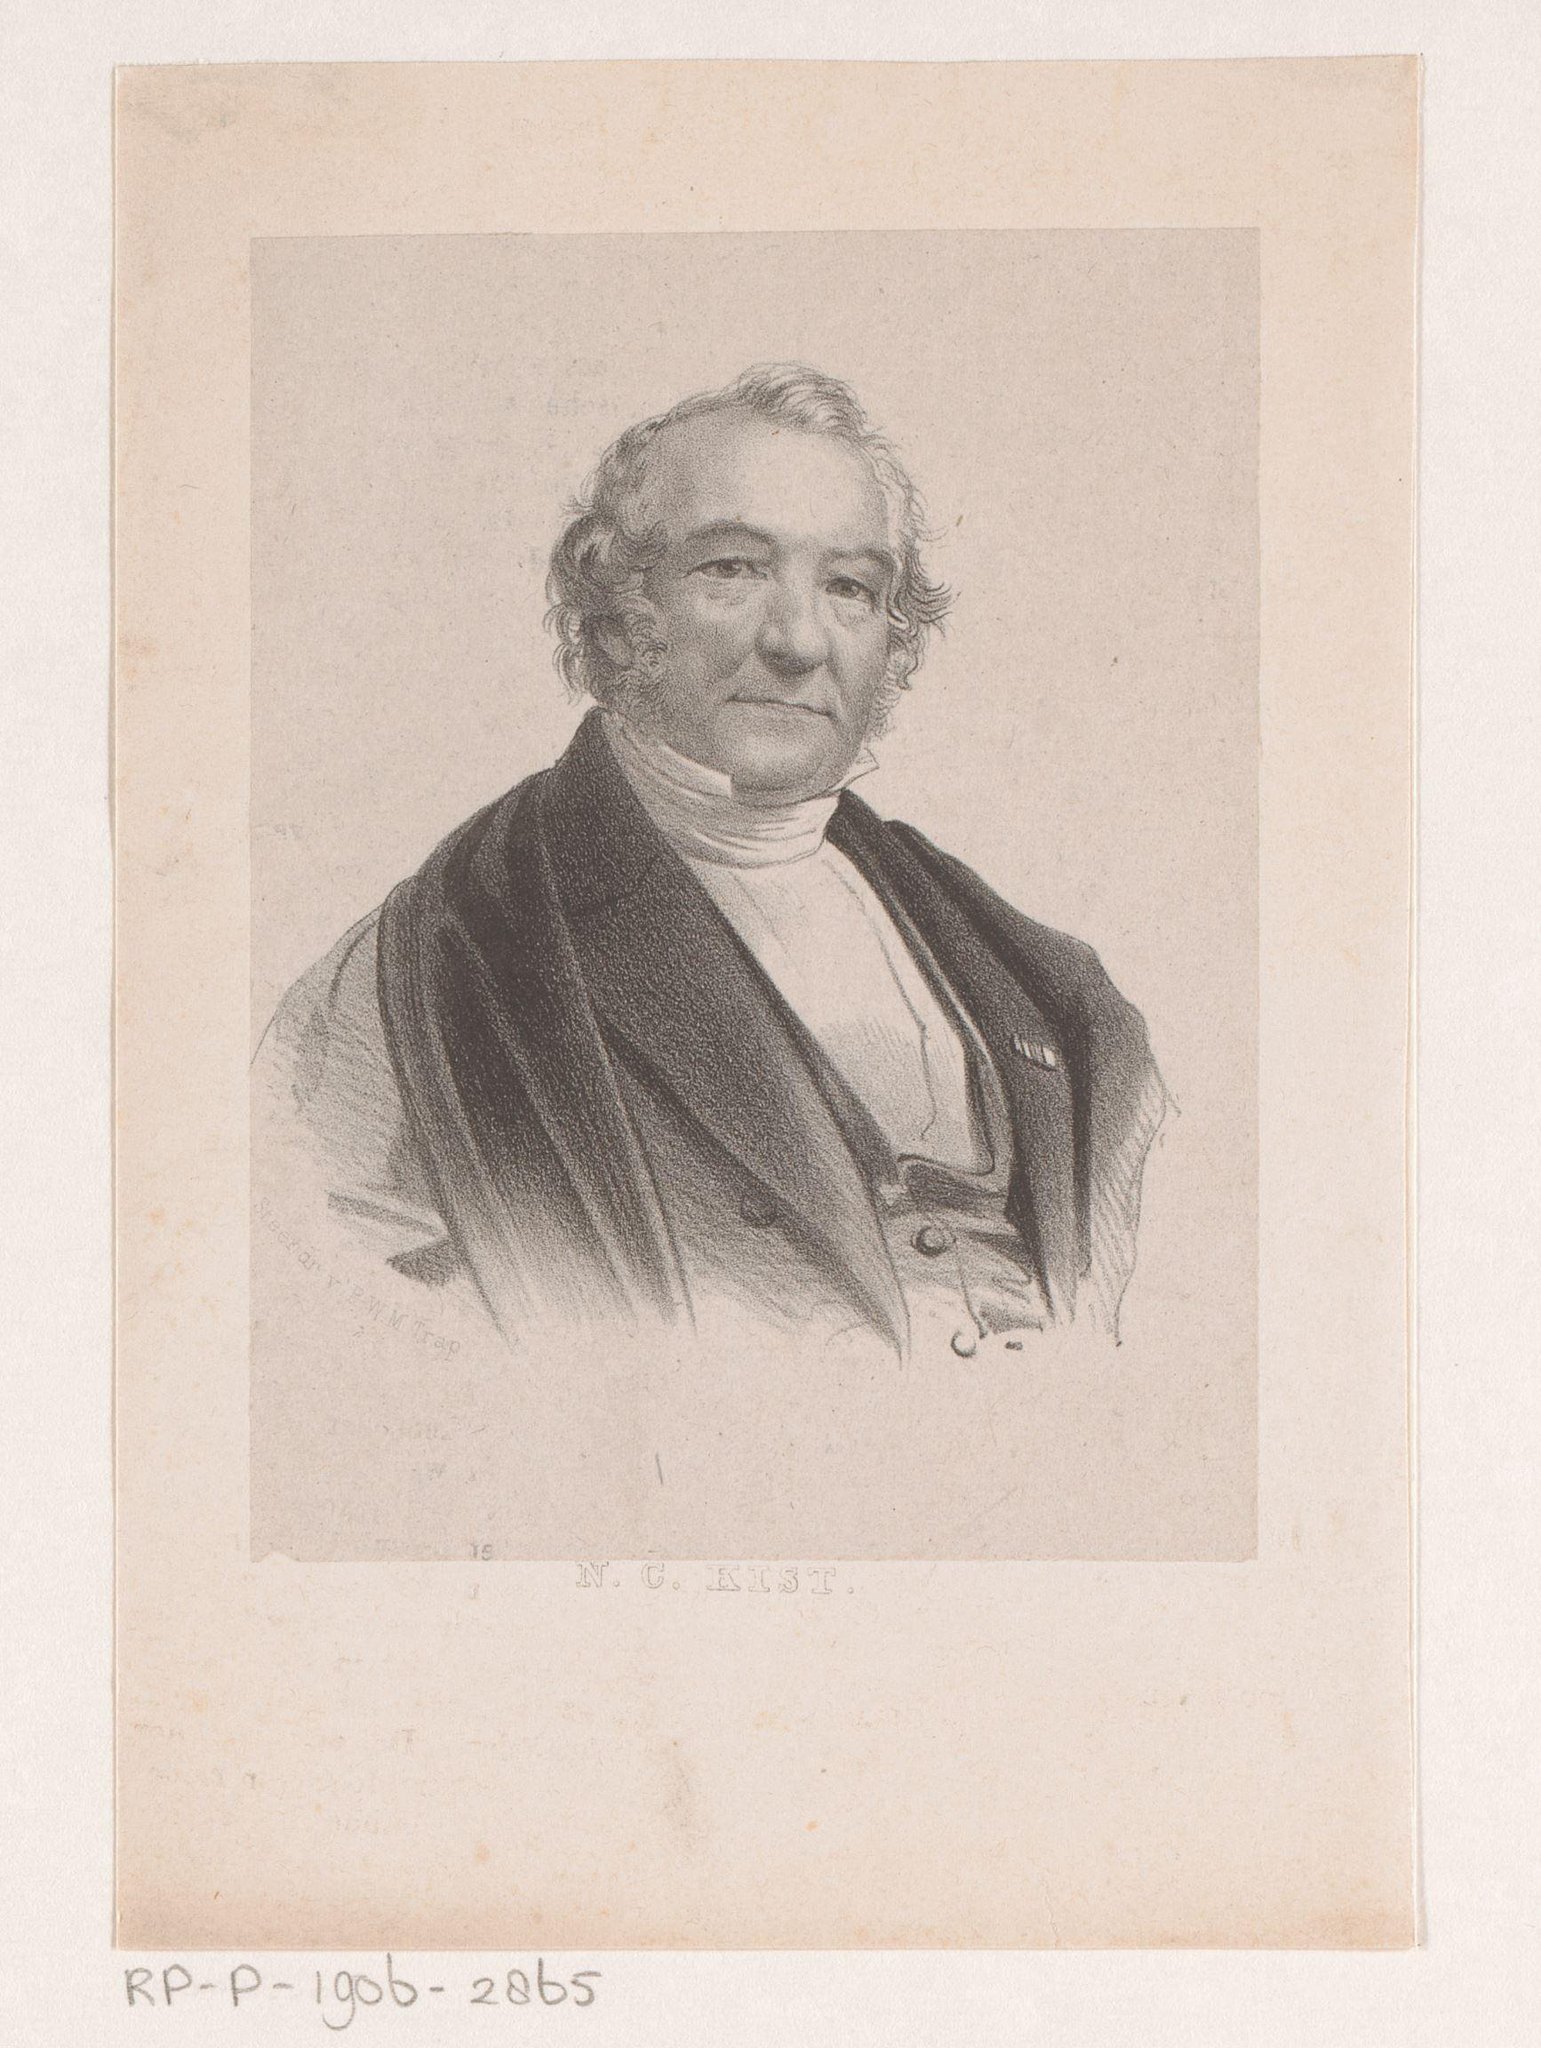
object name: print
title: N.C. Kist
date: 1860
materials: paper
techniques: lithograph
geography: leiden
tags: leiden, historical persons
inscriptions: collector's mark: Lugt 2228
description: Prent uit: Maandelijksche Kronijk. Geschiedenis van den dag, 1860, dl. I.